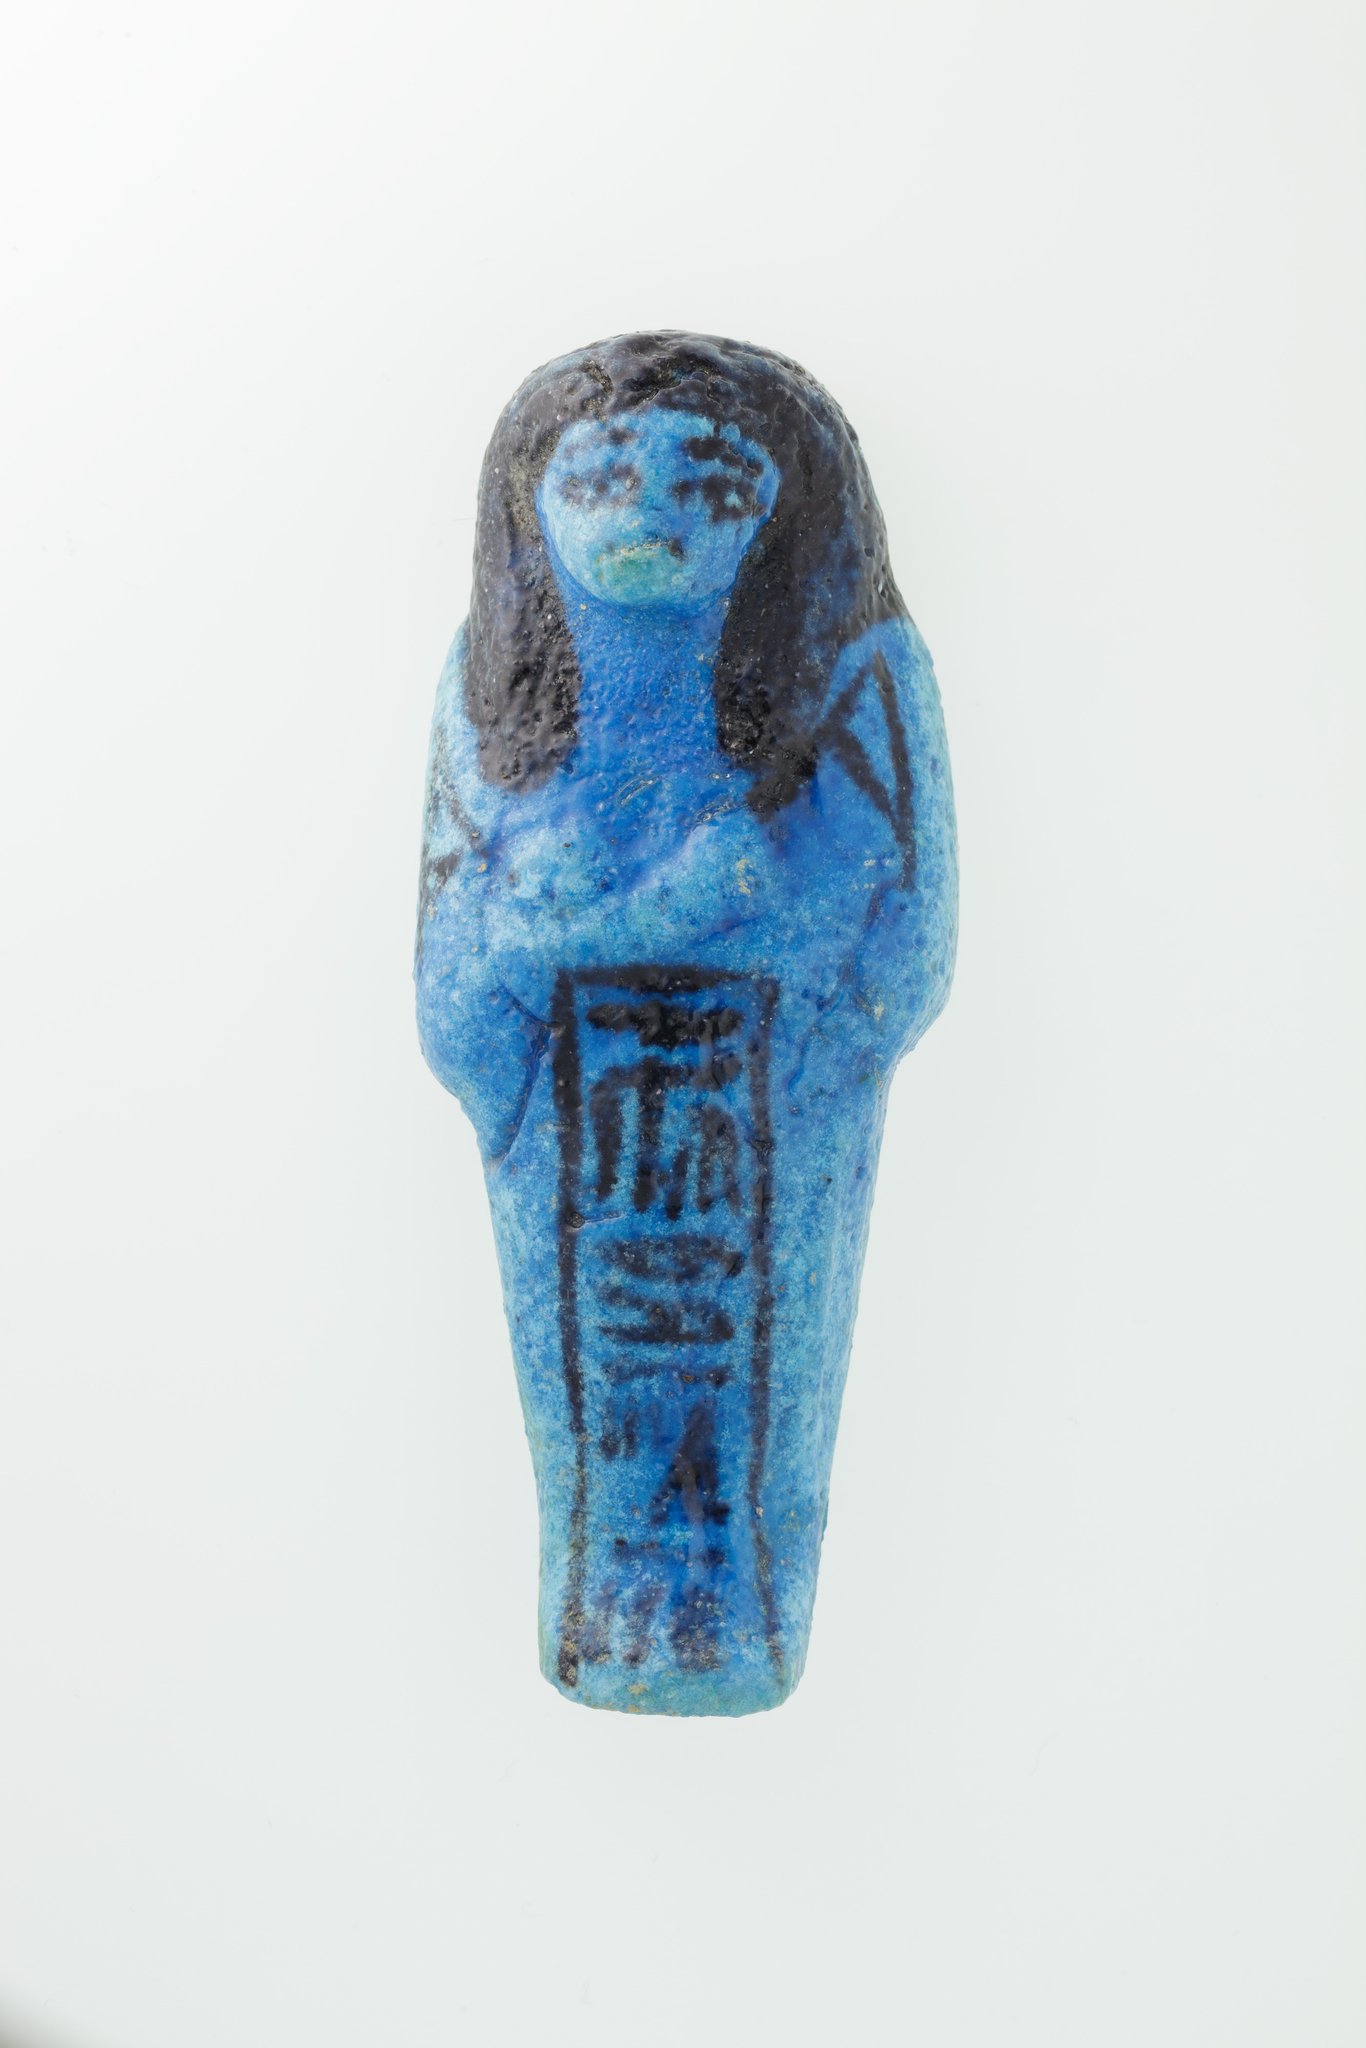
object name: shabti, worker, nauny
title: Worker Shabti of Nauny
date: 1050 BCE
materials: faience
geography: egypt